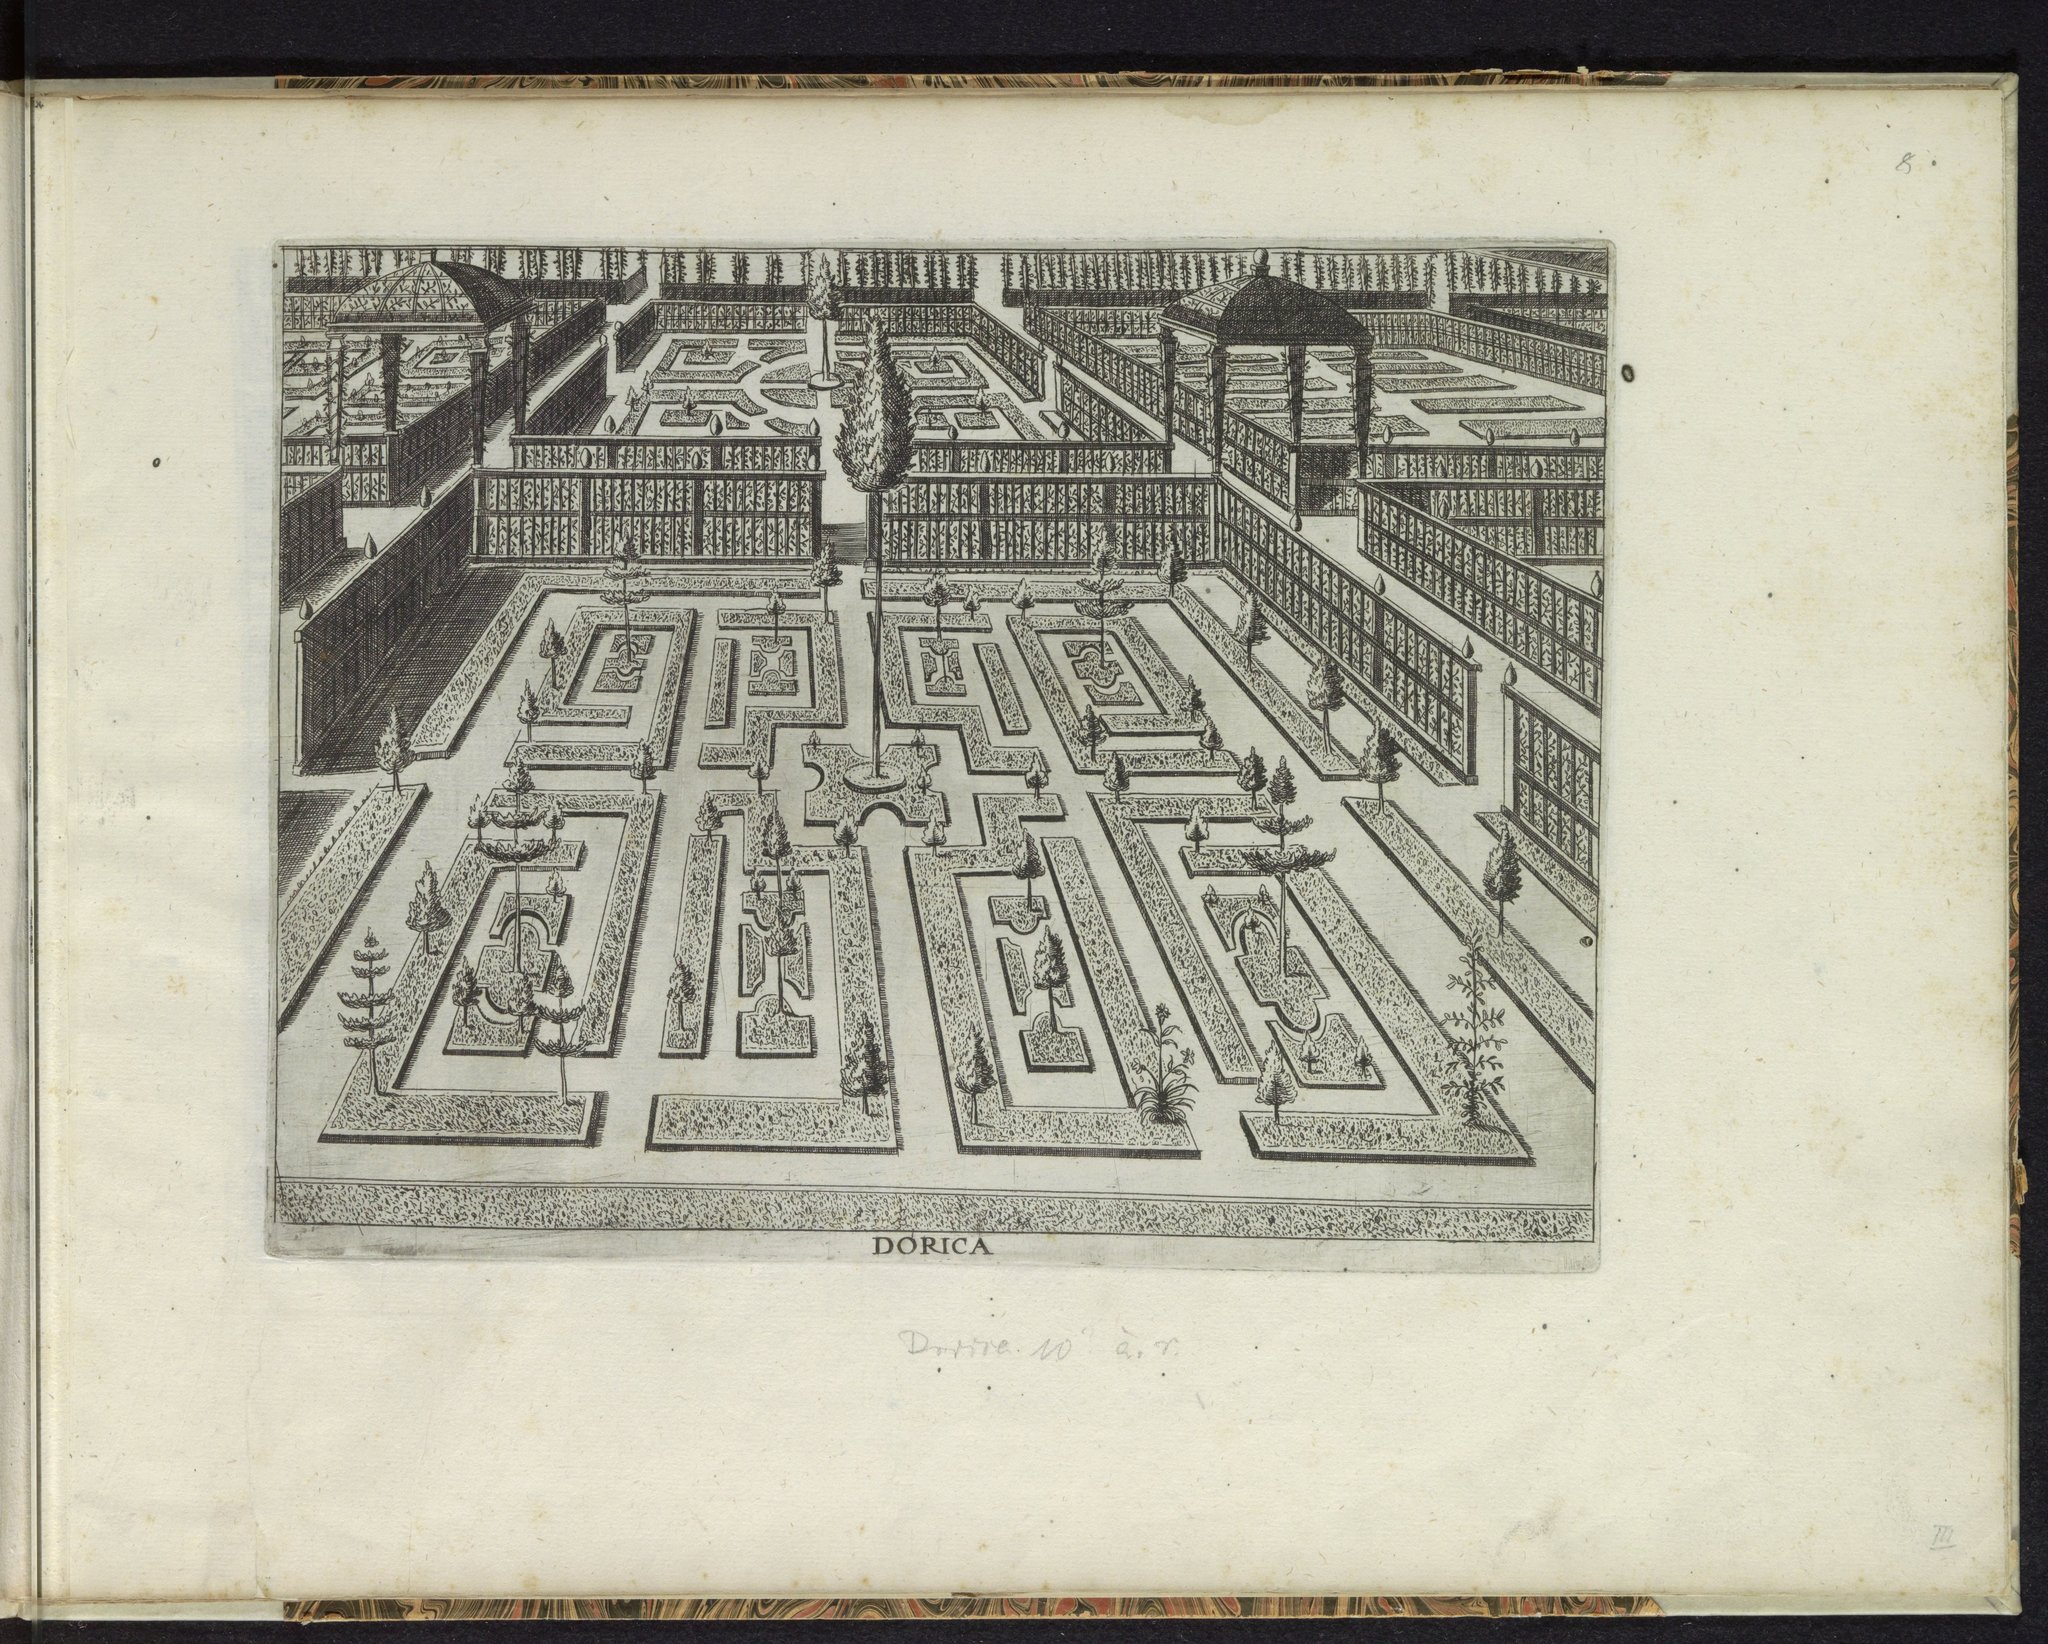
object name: print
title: Tuinontwerpen geassocieerd met de Dorische, Ionische en Korinthische bouworden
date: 1615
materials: paper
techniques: etching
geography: cologne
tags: garden, french or architectonic garden; formal garden, labyrinth, maze ~ garden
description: Tuin met centrale parterre bestaande uit acht rechthoekige compartimenten. Omgeven door hekken waar planten tegenop groeien. De tuin is aangelegd volgens de Dorische bouworde. De prent maakt deel uit van een album.